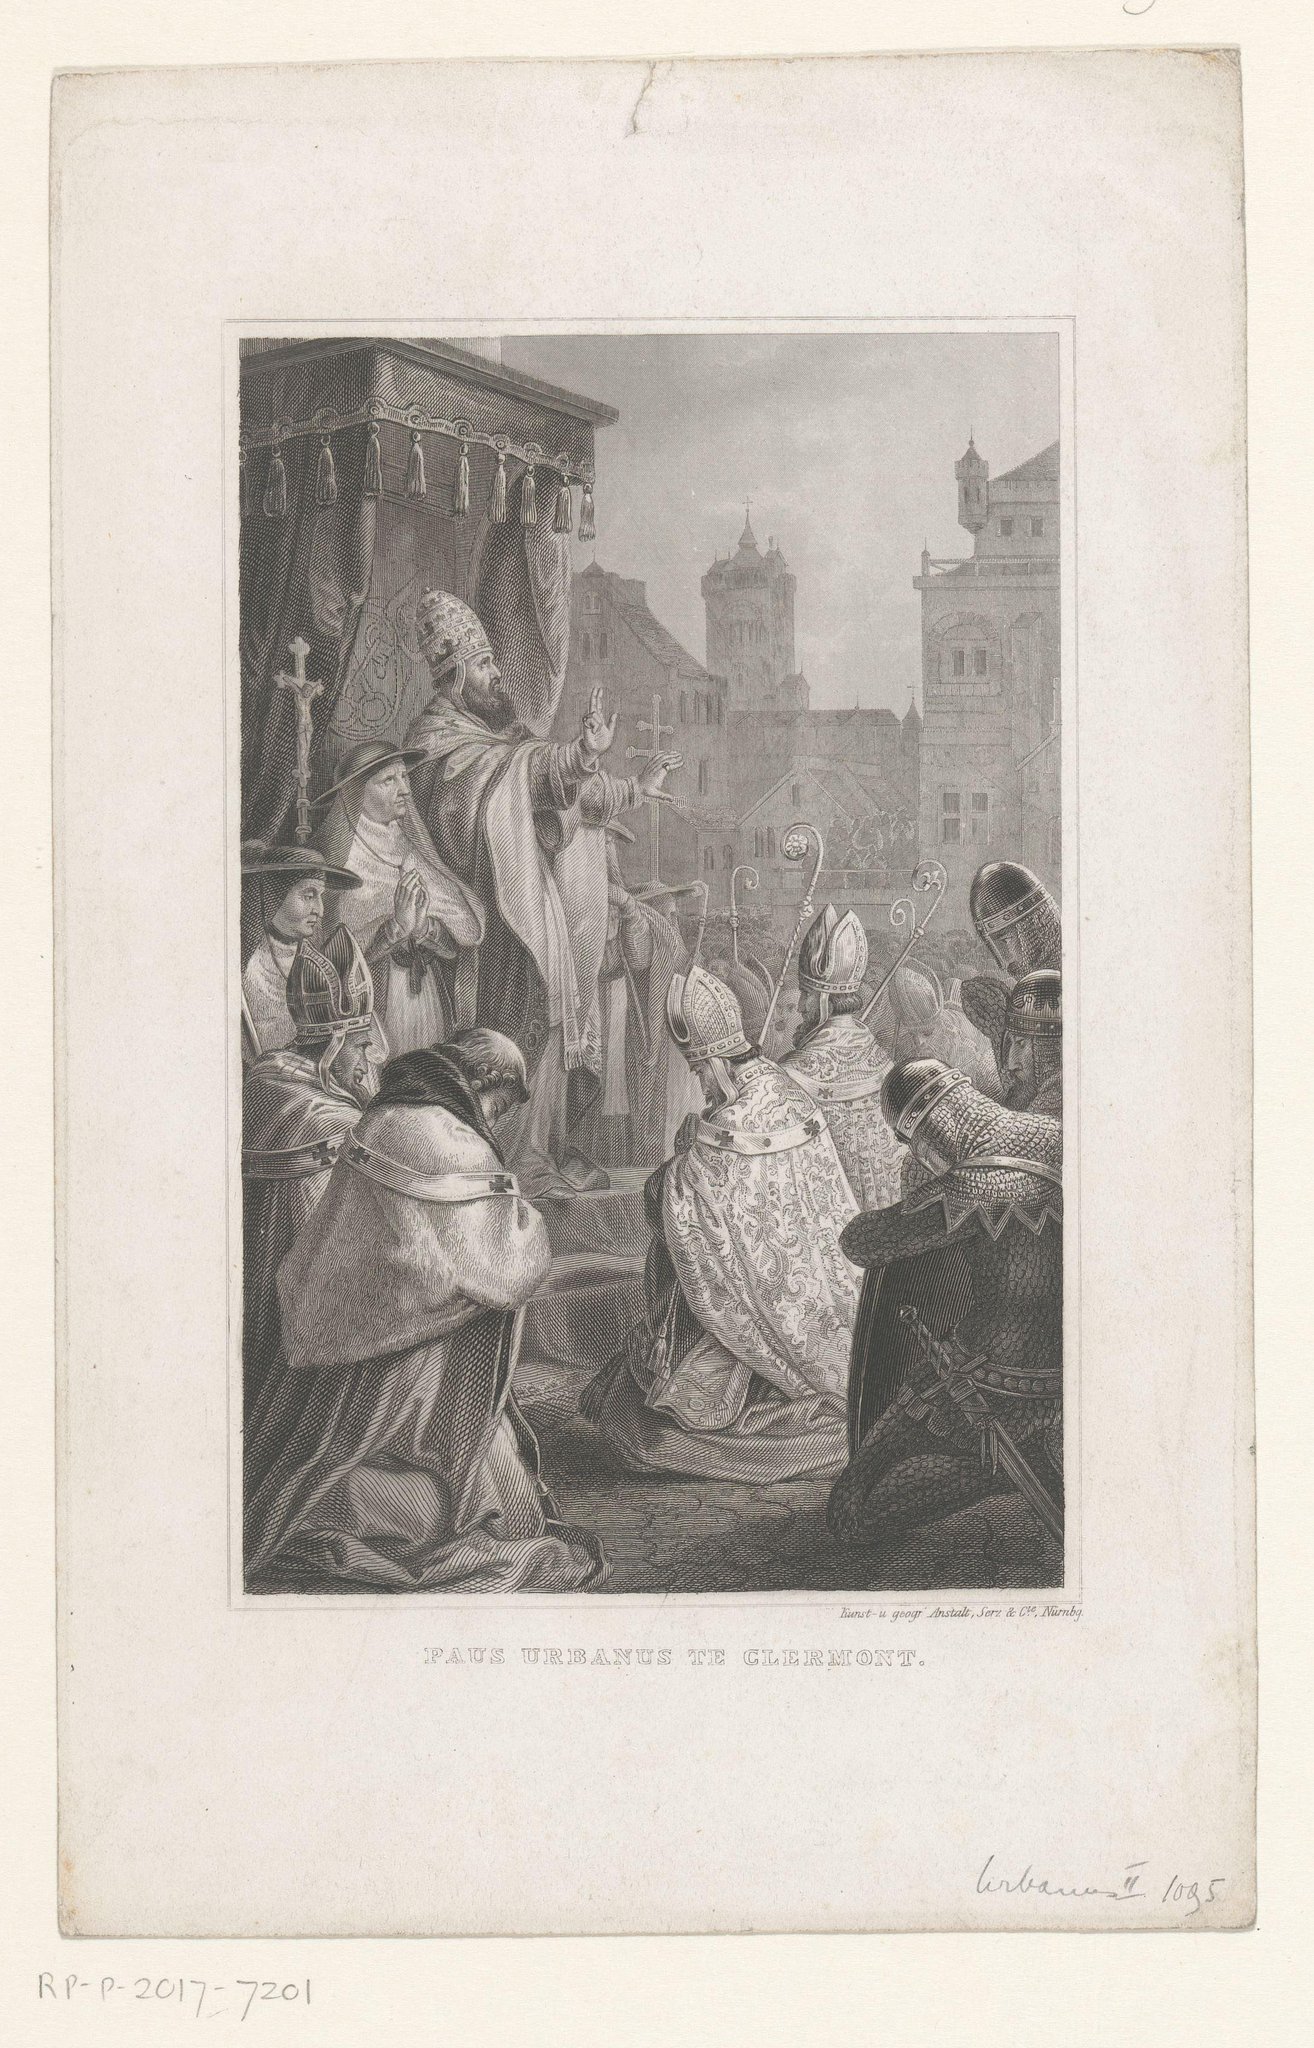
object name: print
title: Paus Urbanus II te Clermont-Ferrand, 1095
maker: Anonymous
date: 1800-1899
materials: paper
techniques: engraving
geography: nuremberg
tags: rome, militant proselytizing: religious war, crusade, etc., preaching (in general), pope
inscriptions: collector's mark: Lugt 2228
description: Paus Urbanus II te Clermont-Ferrand, 1095. De aus sprkend in het openbaar op een plein, voor hem knielende bisschoppen en ridders. Mogelijk betreft het hier het Concilie van Clermont-Ferrand op 18 november 1095 met de oproep tot de Eerste Kruistocht.